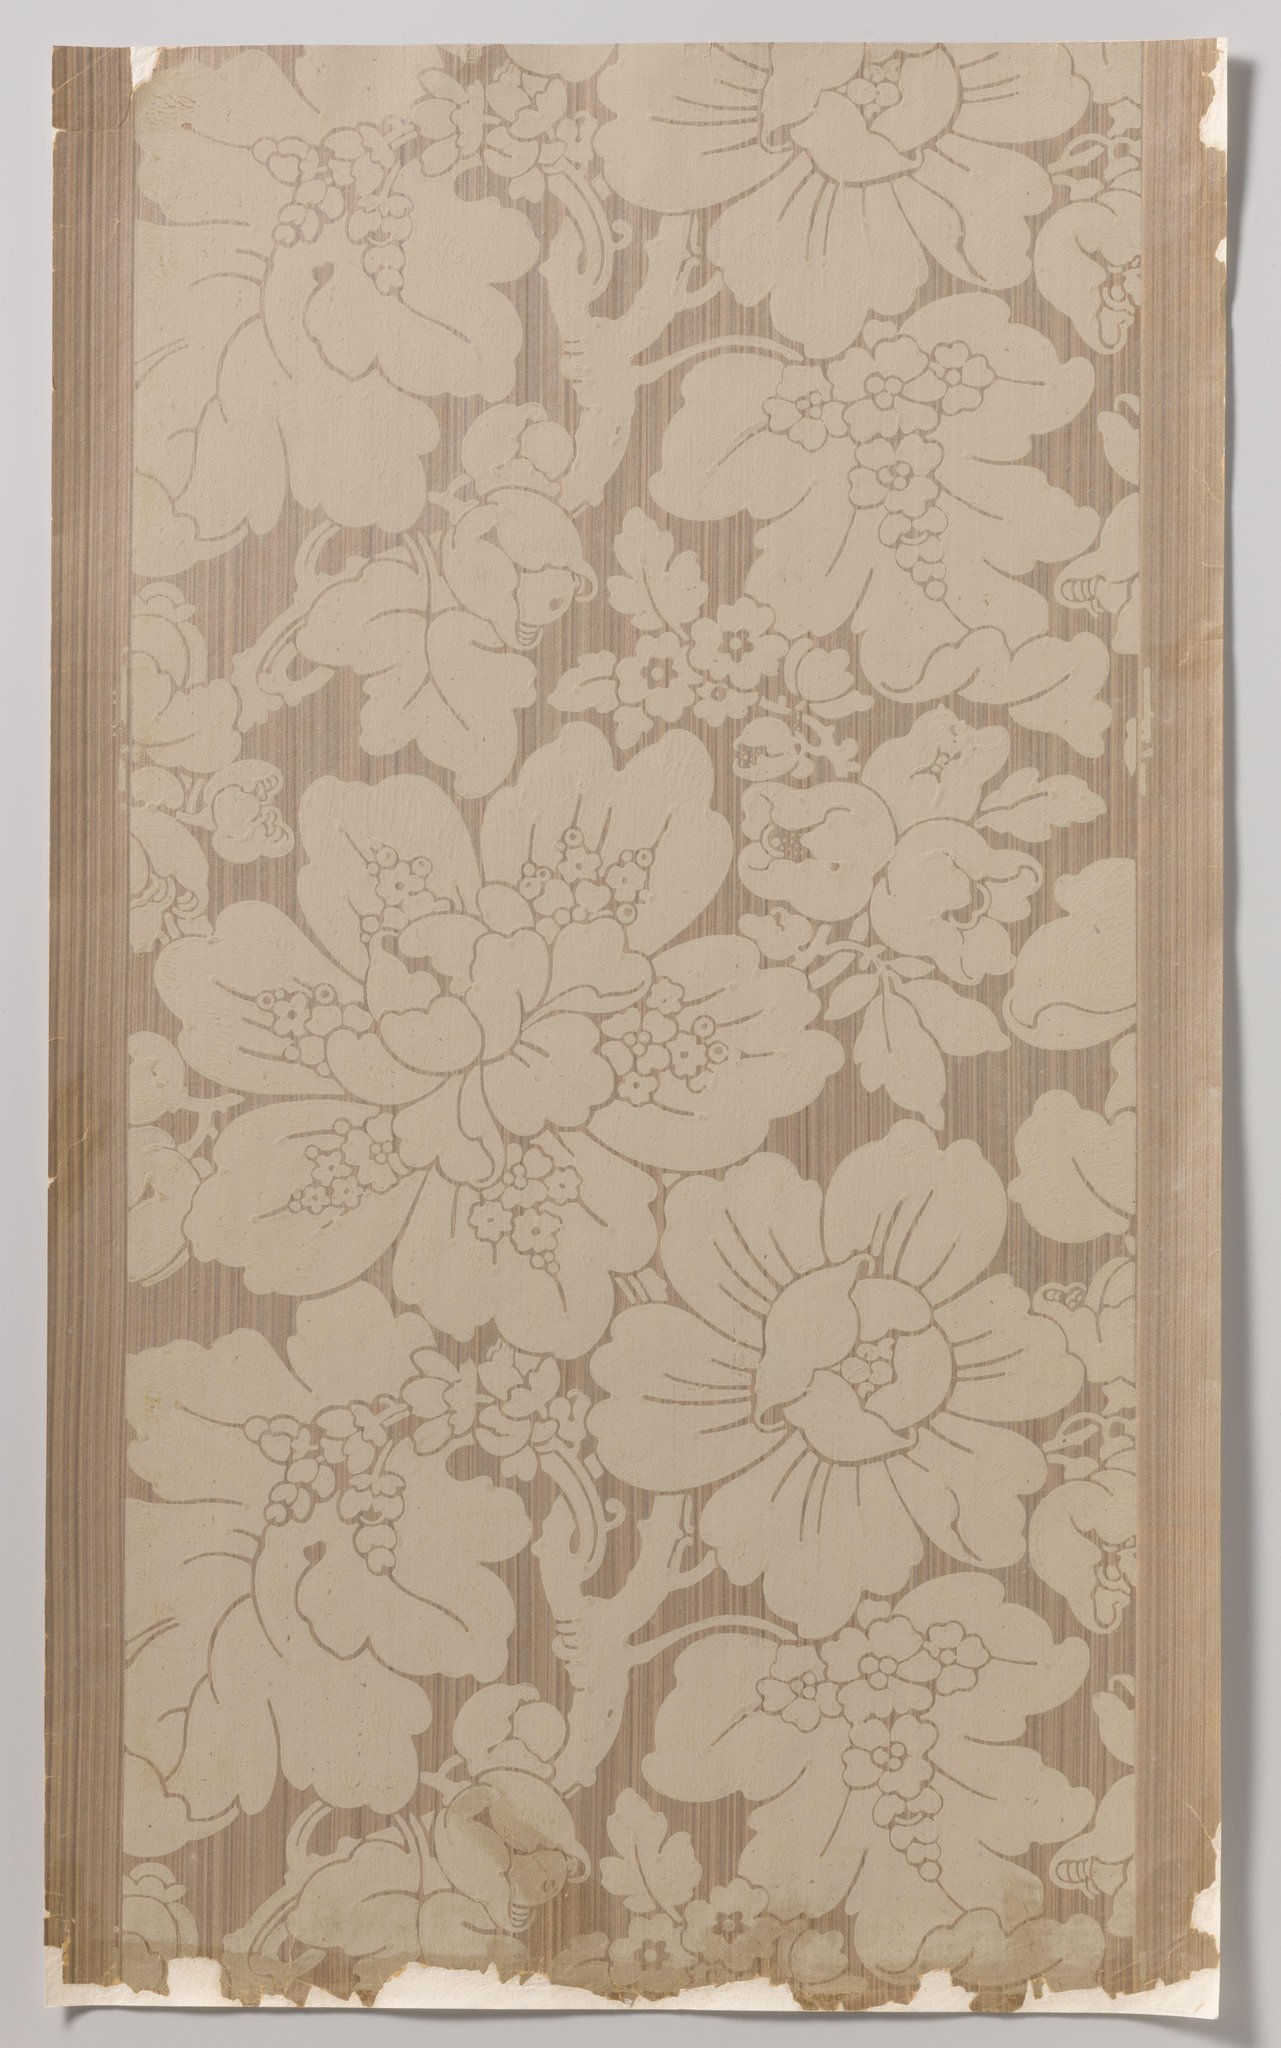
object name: wallpaper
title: Papierbehangsel met patroon van bloemen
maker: jules desfossé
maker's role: behangselfabrikant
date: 1860-1920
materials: paper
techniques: printing block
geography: paris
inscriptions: inscription: ‘7952 31A’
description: Papierbehangsel met een patroon van beige bloemen op een bruin/beige geborsteld fond met zogenaamd faux-bos effect (houteffect). Blokdruk met doorlopend patroon op een gematteerd fond.